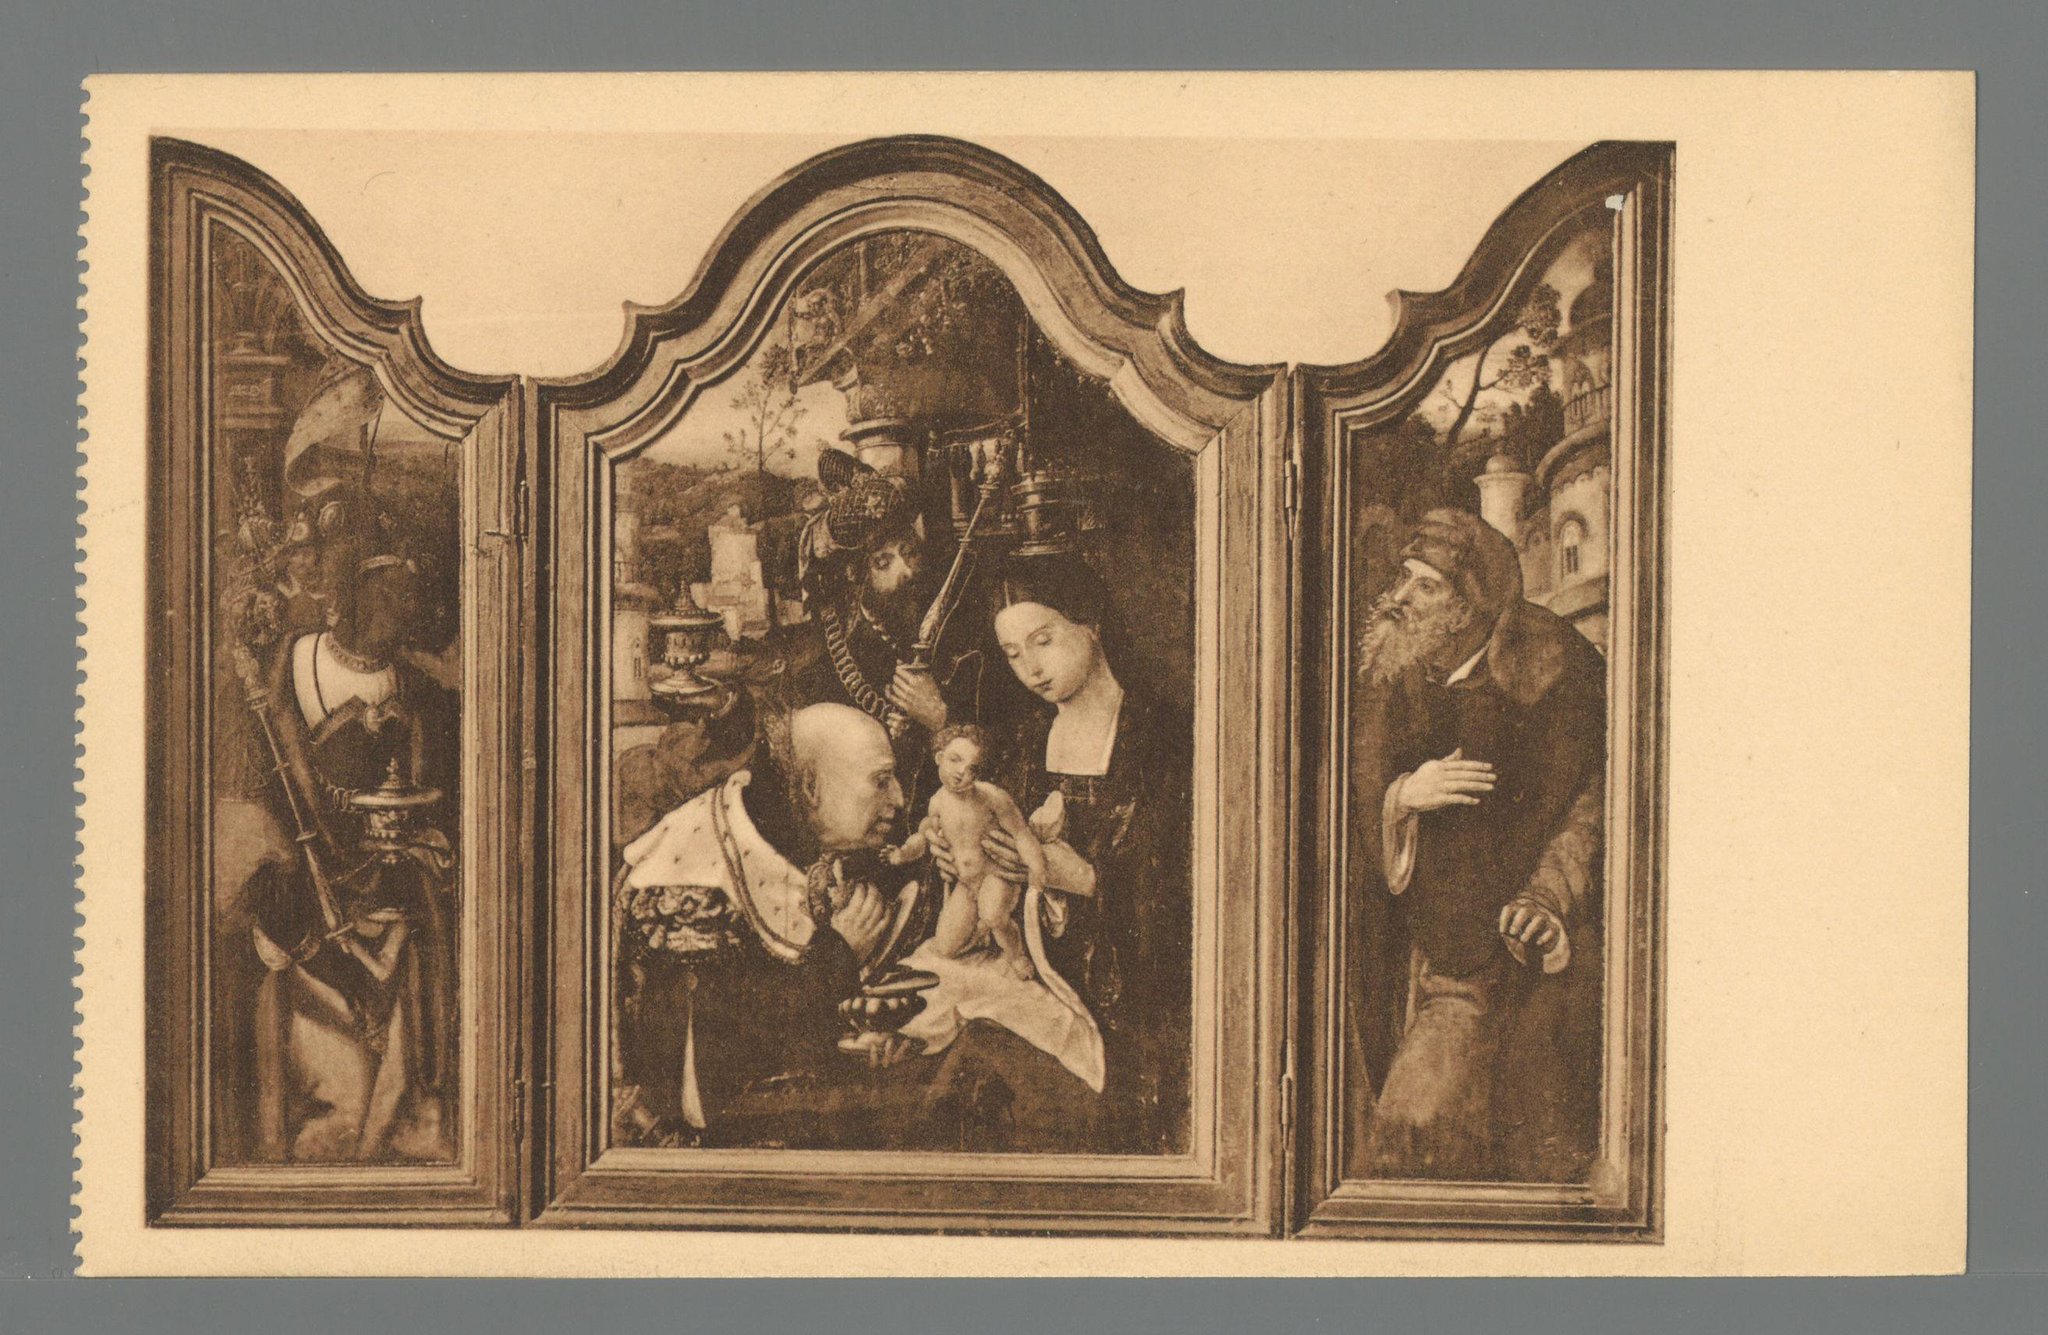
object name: photomechanical print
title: Aartsb. Museum, Utrecht. De aanbidding der Wijzen (Meester der Utrechtsche aanbidding). Begin XVIde eeuw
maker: Anonymous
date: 1908-1921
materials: cardboard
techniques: photograph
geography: rotterdam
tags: permanent exhibition, museum, picture, painting